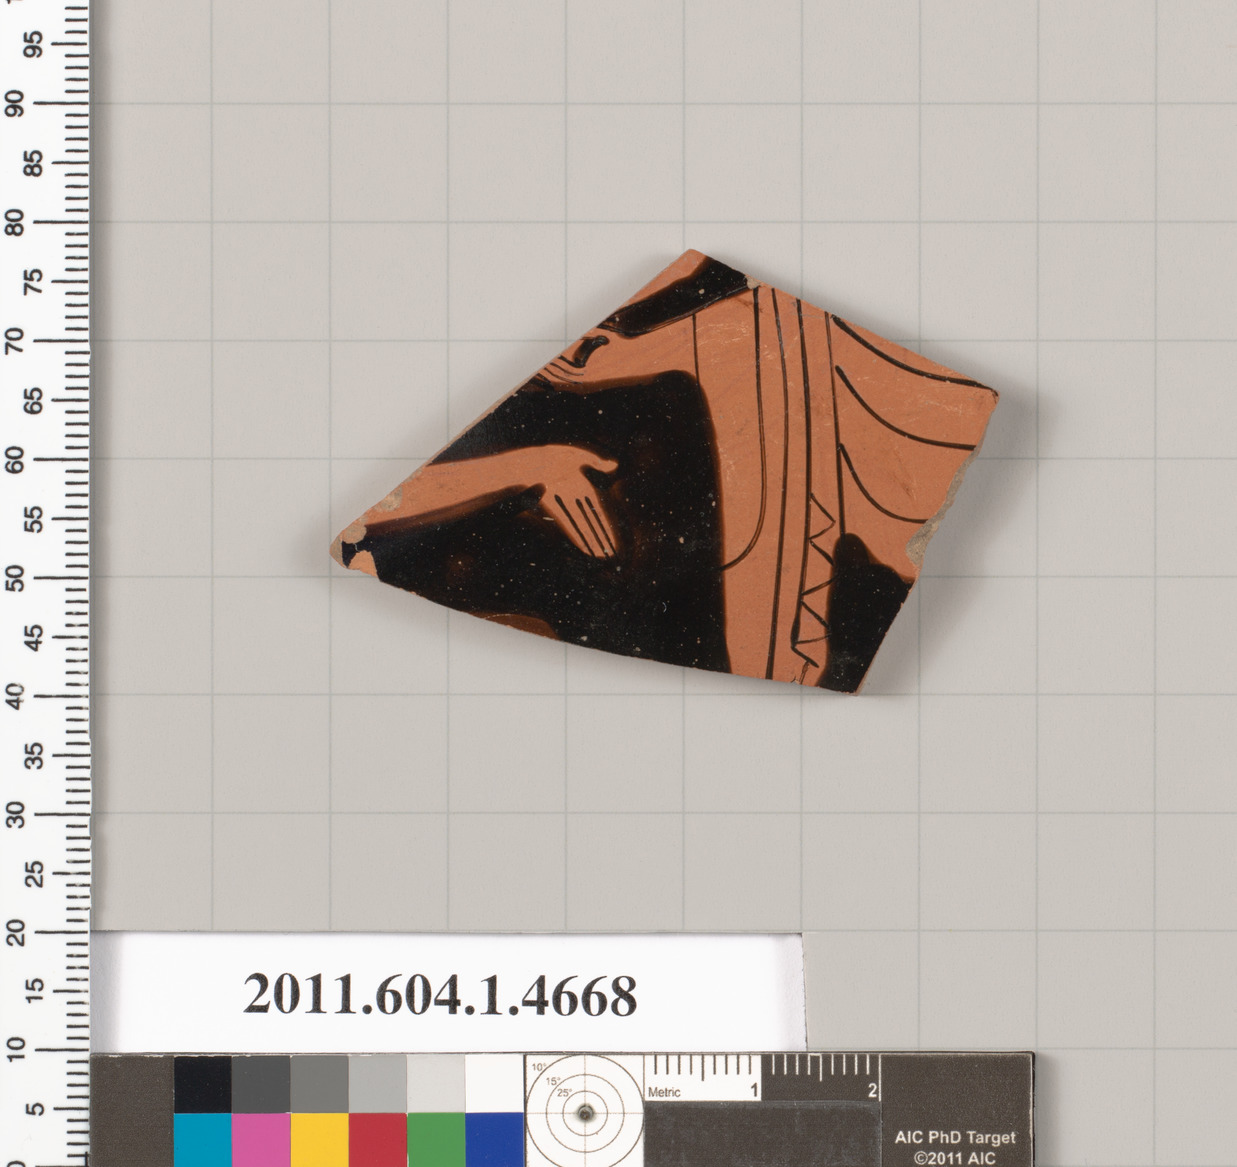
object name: kylix fragment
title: Terracotta fragment of a kylix (drinking cup)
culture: greek, attic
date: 490-470 BCE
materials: terracotta